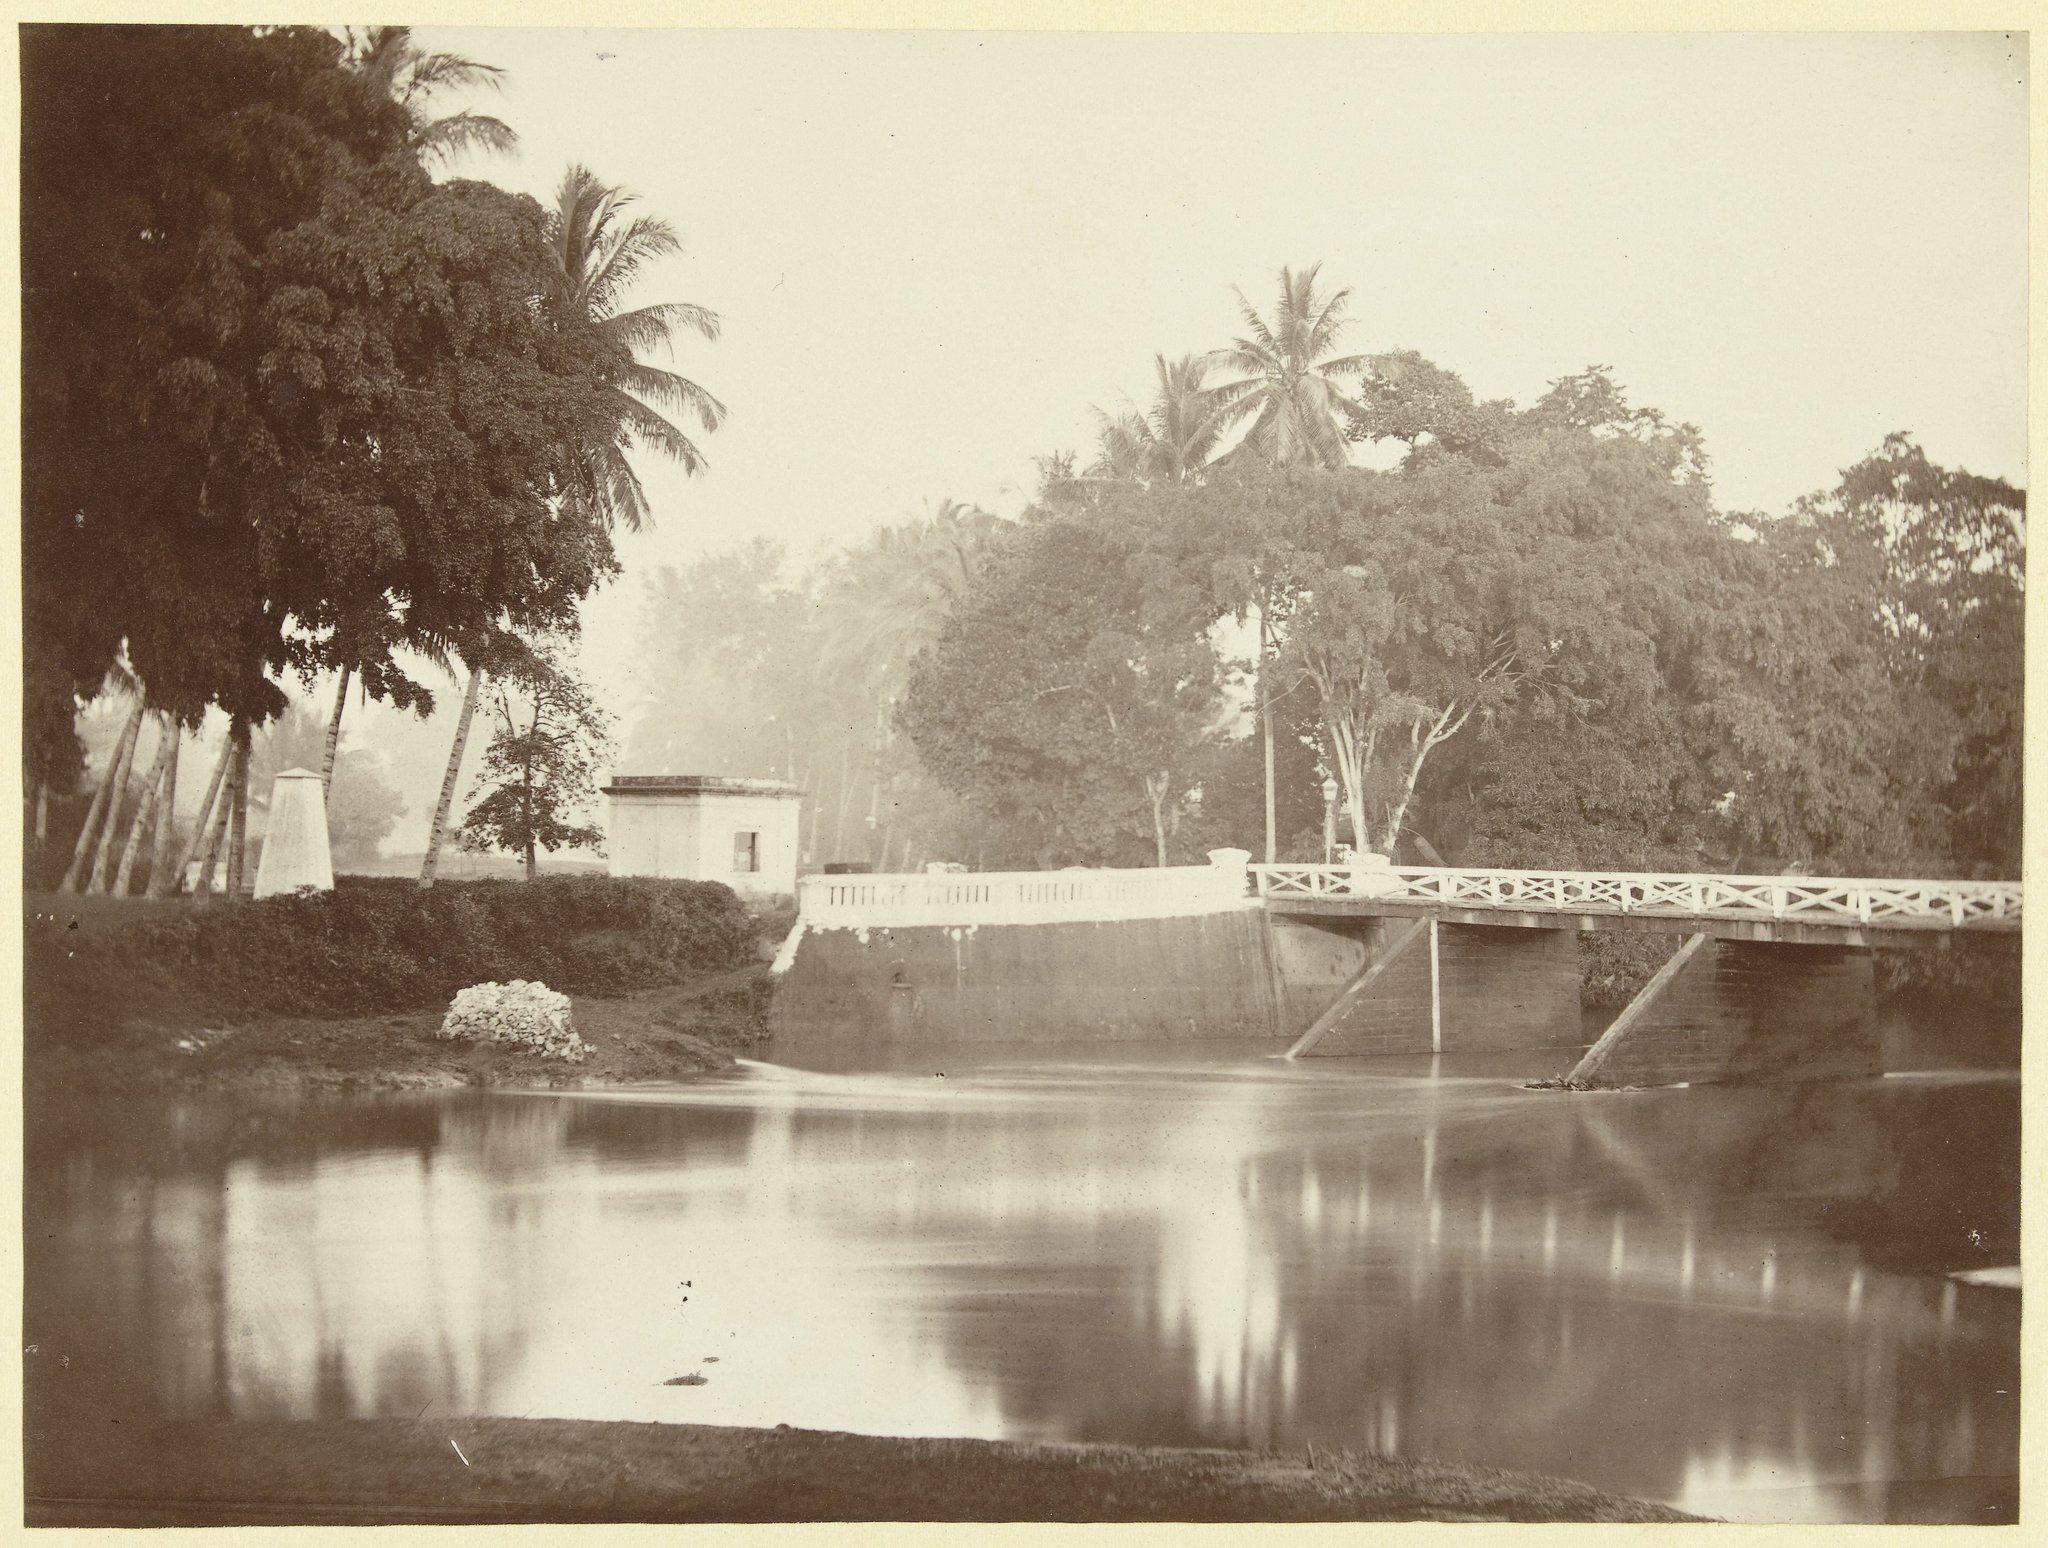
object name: photograph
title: Gezicht op de Ciliwung in Batavia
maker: jacobus anthonie meessen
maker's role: fotograaf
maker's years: 1836-1885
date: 1864-1869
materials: cardboard, paper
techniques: albumen print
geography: dutch east indies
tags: river, batavia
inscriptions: title: ‘22. Kampong Tjiliwong (Batavia)’, inscription: ‘Java’